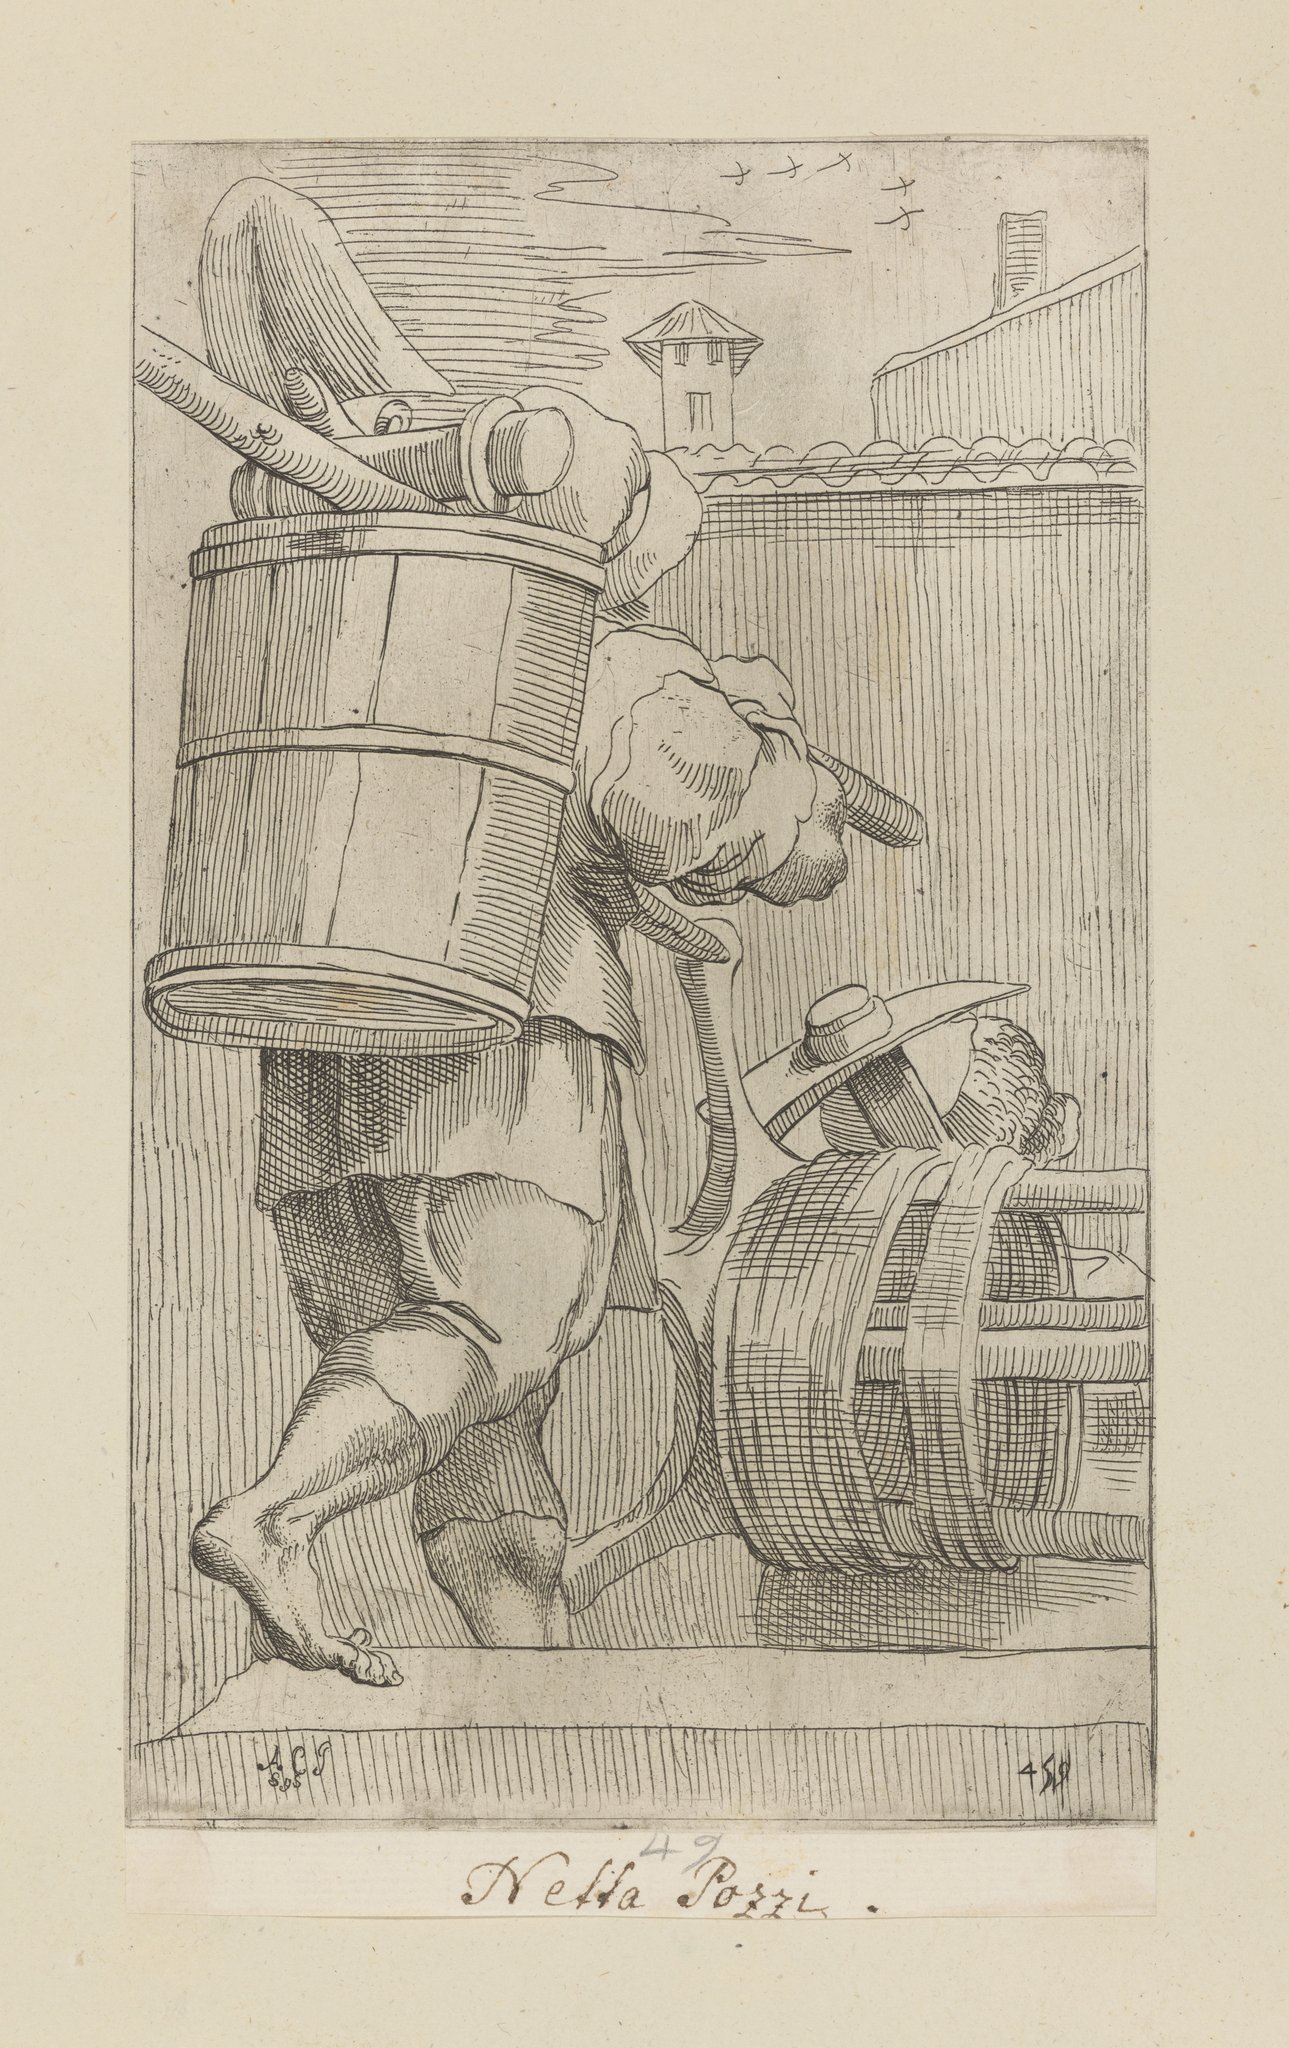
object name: print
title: Plate 45: well cleaner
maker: simon guillain ii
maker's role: artist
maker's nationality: french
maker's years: 1618-1718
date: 1646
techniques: etching